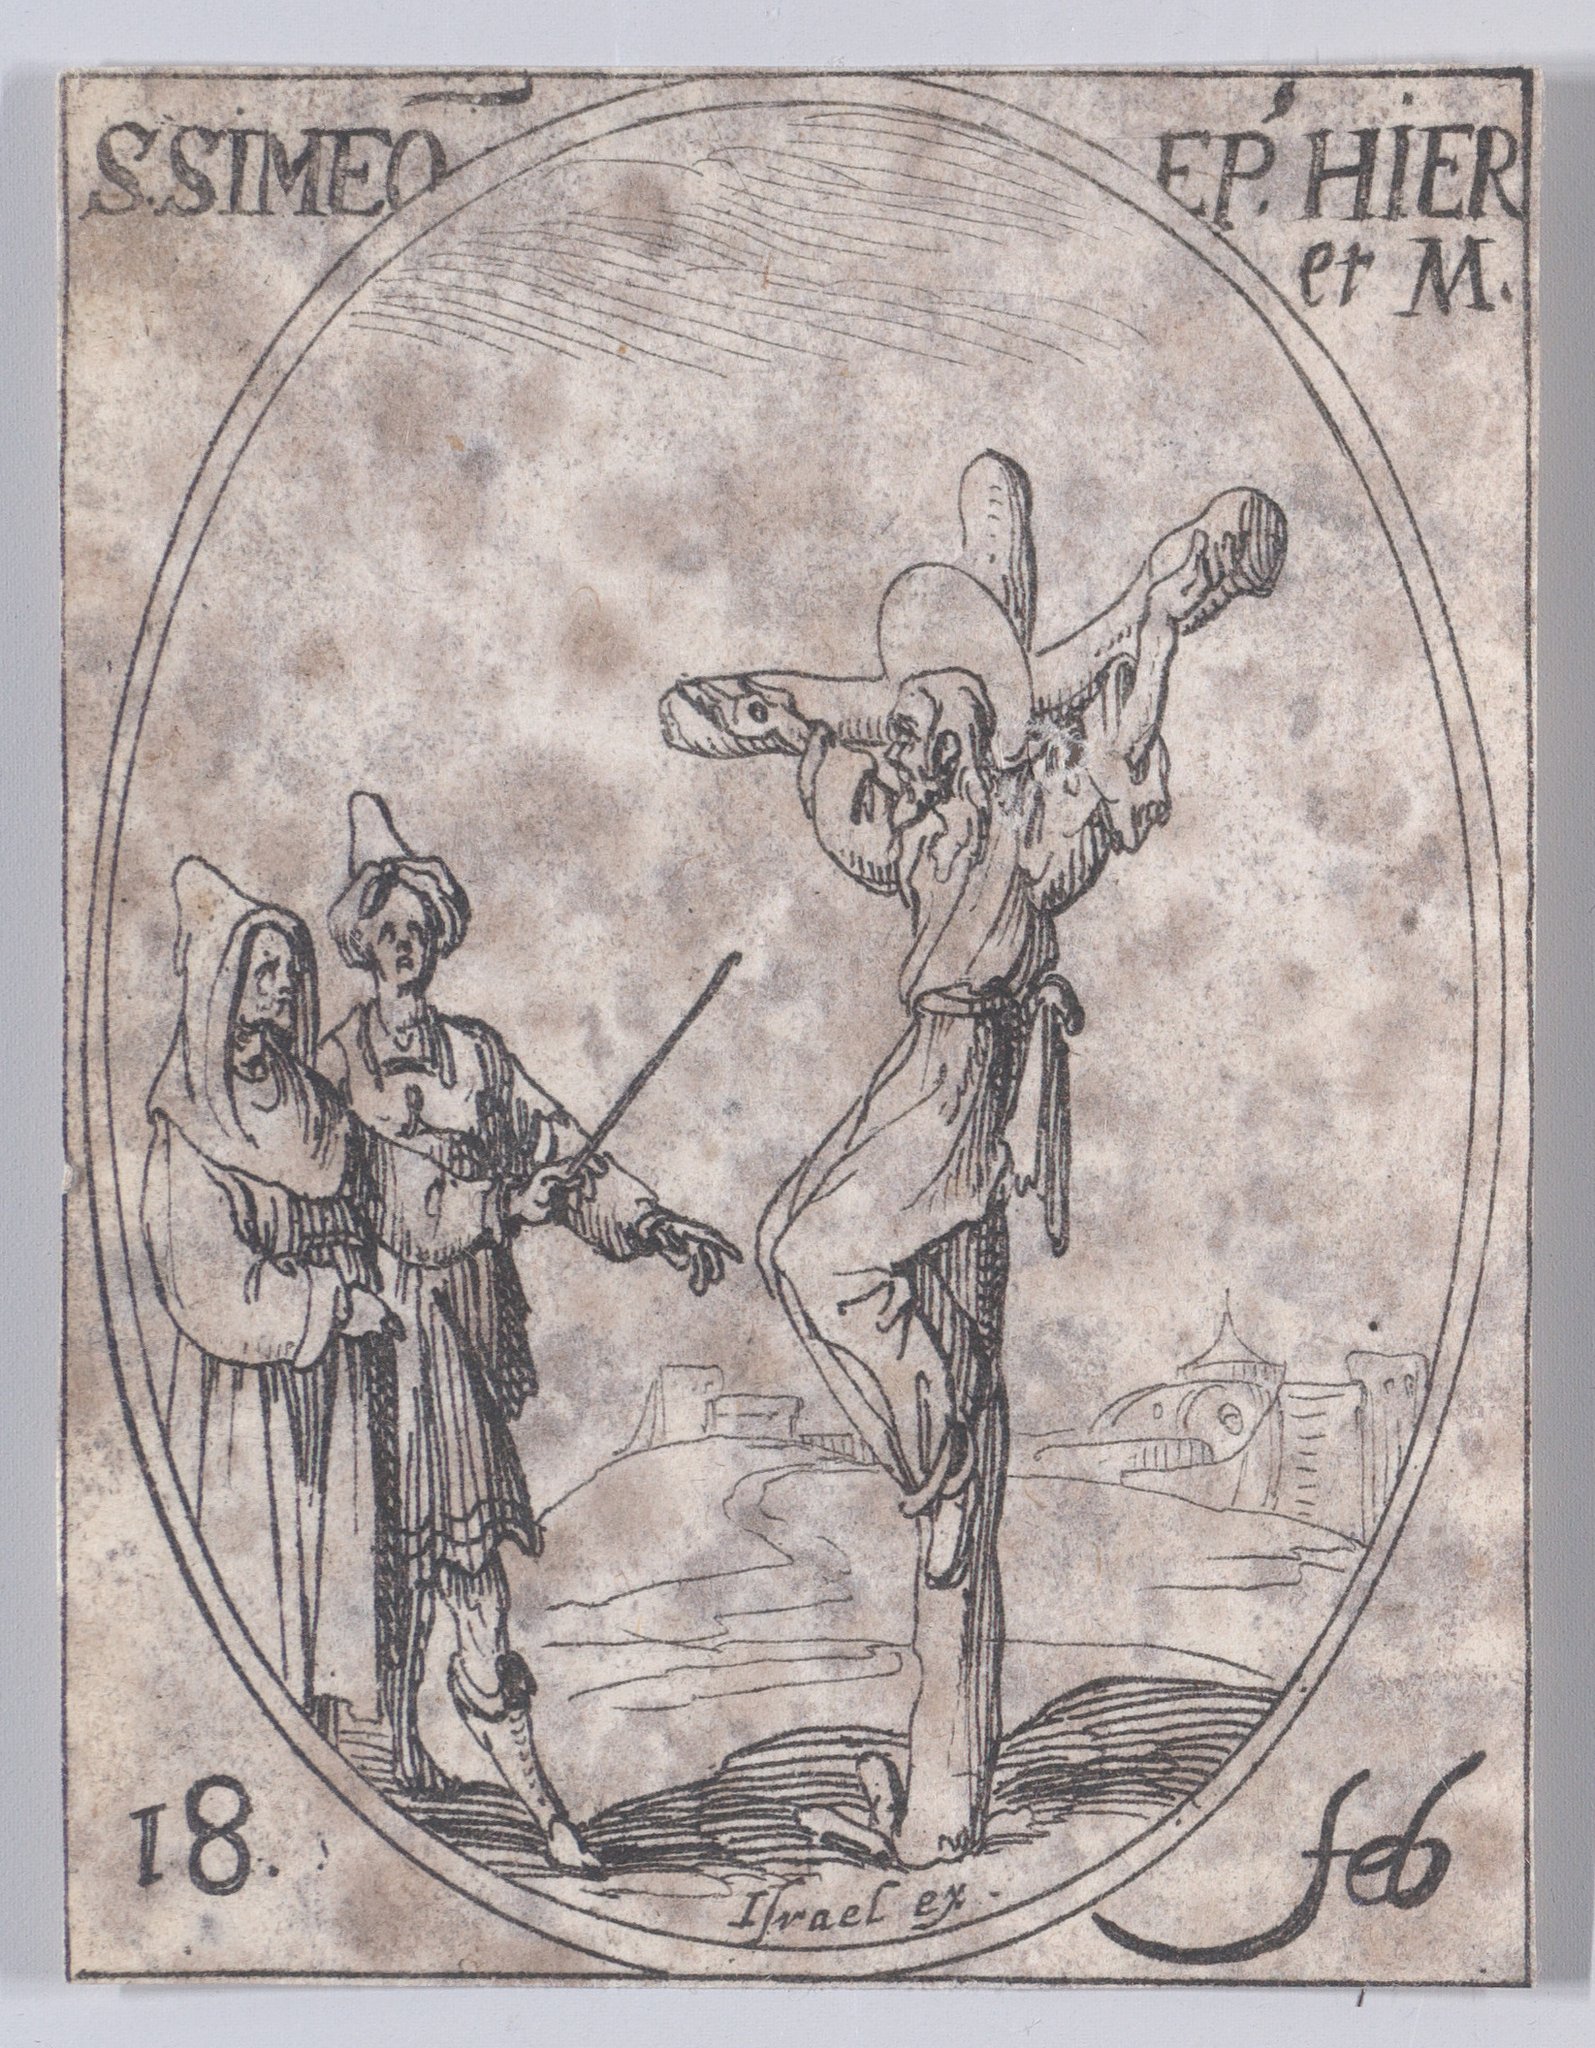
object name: print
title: S. Siméon, évêque de Jérusalem, martyr (St. Simeon, Bishop of Jerusalem, Martyr), February 18th, from "Les Images De Tous Les Saincts et Saintes de L'Année" (Images of All of the Saints and Religious Events of the Year)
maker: jacques callot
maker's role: artist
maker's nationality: french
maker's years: 1592-1635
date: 1636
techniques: etching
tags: men,crucifixion,saints